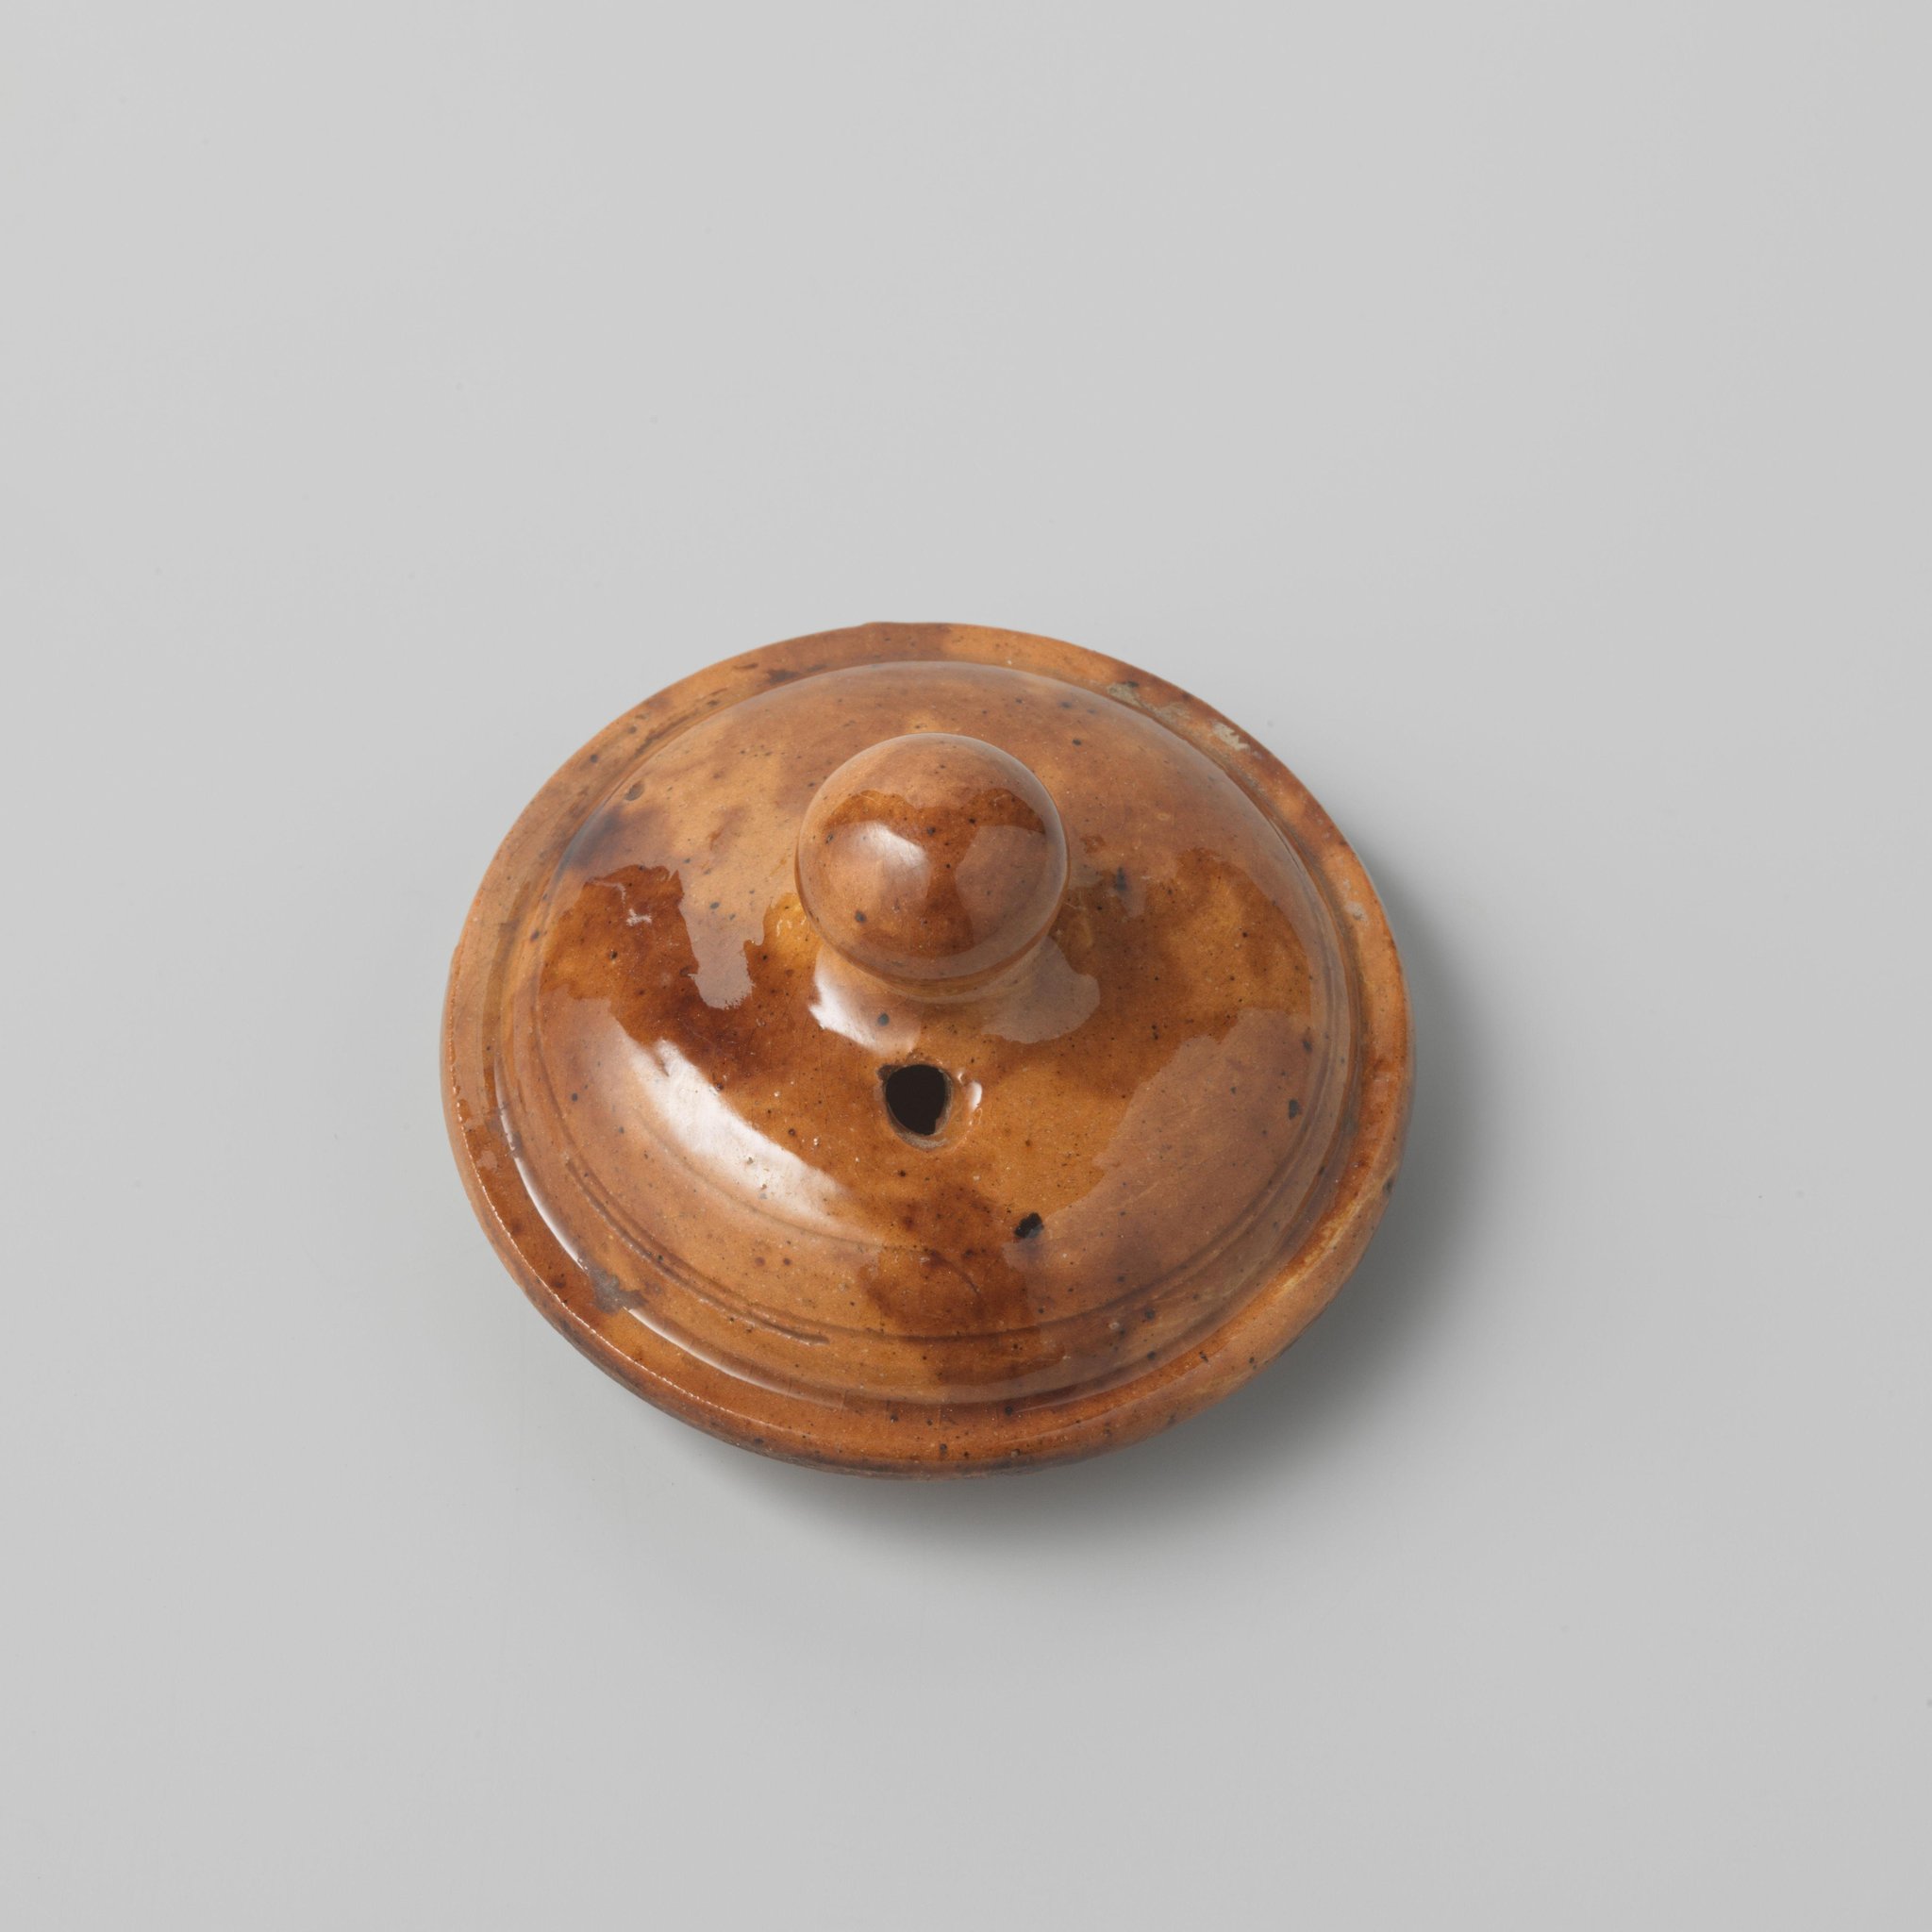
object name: lid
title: Deksel van een theepot (De Caluwe bakafval)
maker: jacobus de caluwe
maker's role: plateelbakkerij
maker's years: -1730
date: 1700-1725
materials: earthenware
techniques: firing, vitrification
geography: delft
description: Toegeschreven aan Jacobus de Caluwe, omdat dit voorwerp samen met gemerkte stukken (‘Jacobus De Caluwe’ en rennend hert) gevonden is op de plaats waar zich De Caluwes tweede werkplaats bevond. Er is een duidelijke stilistische overeenkomst tussen de gemerkte en niet gemerkte voorwerpen uit deze archeologische vondst.